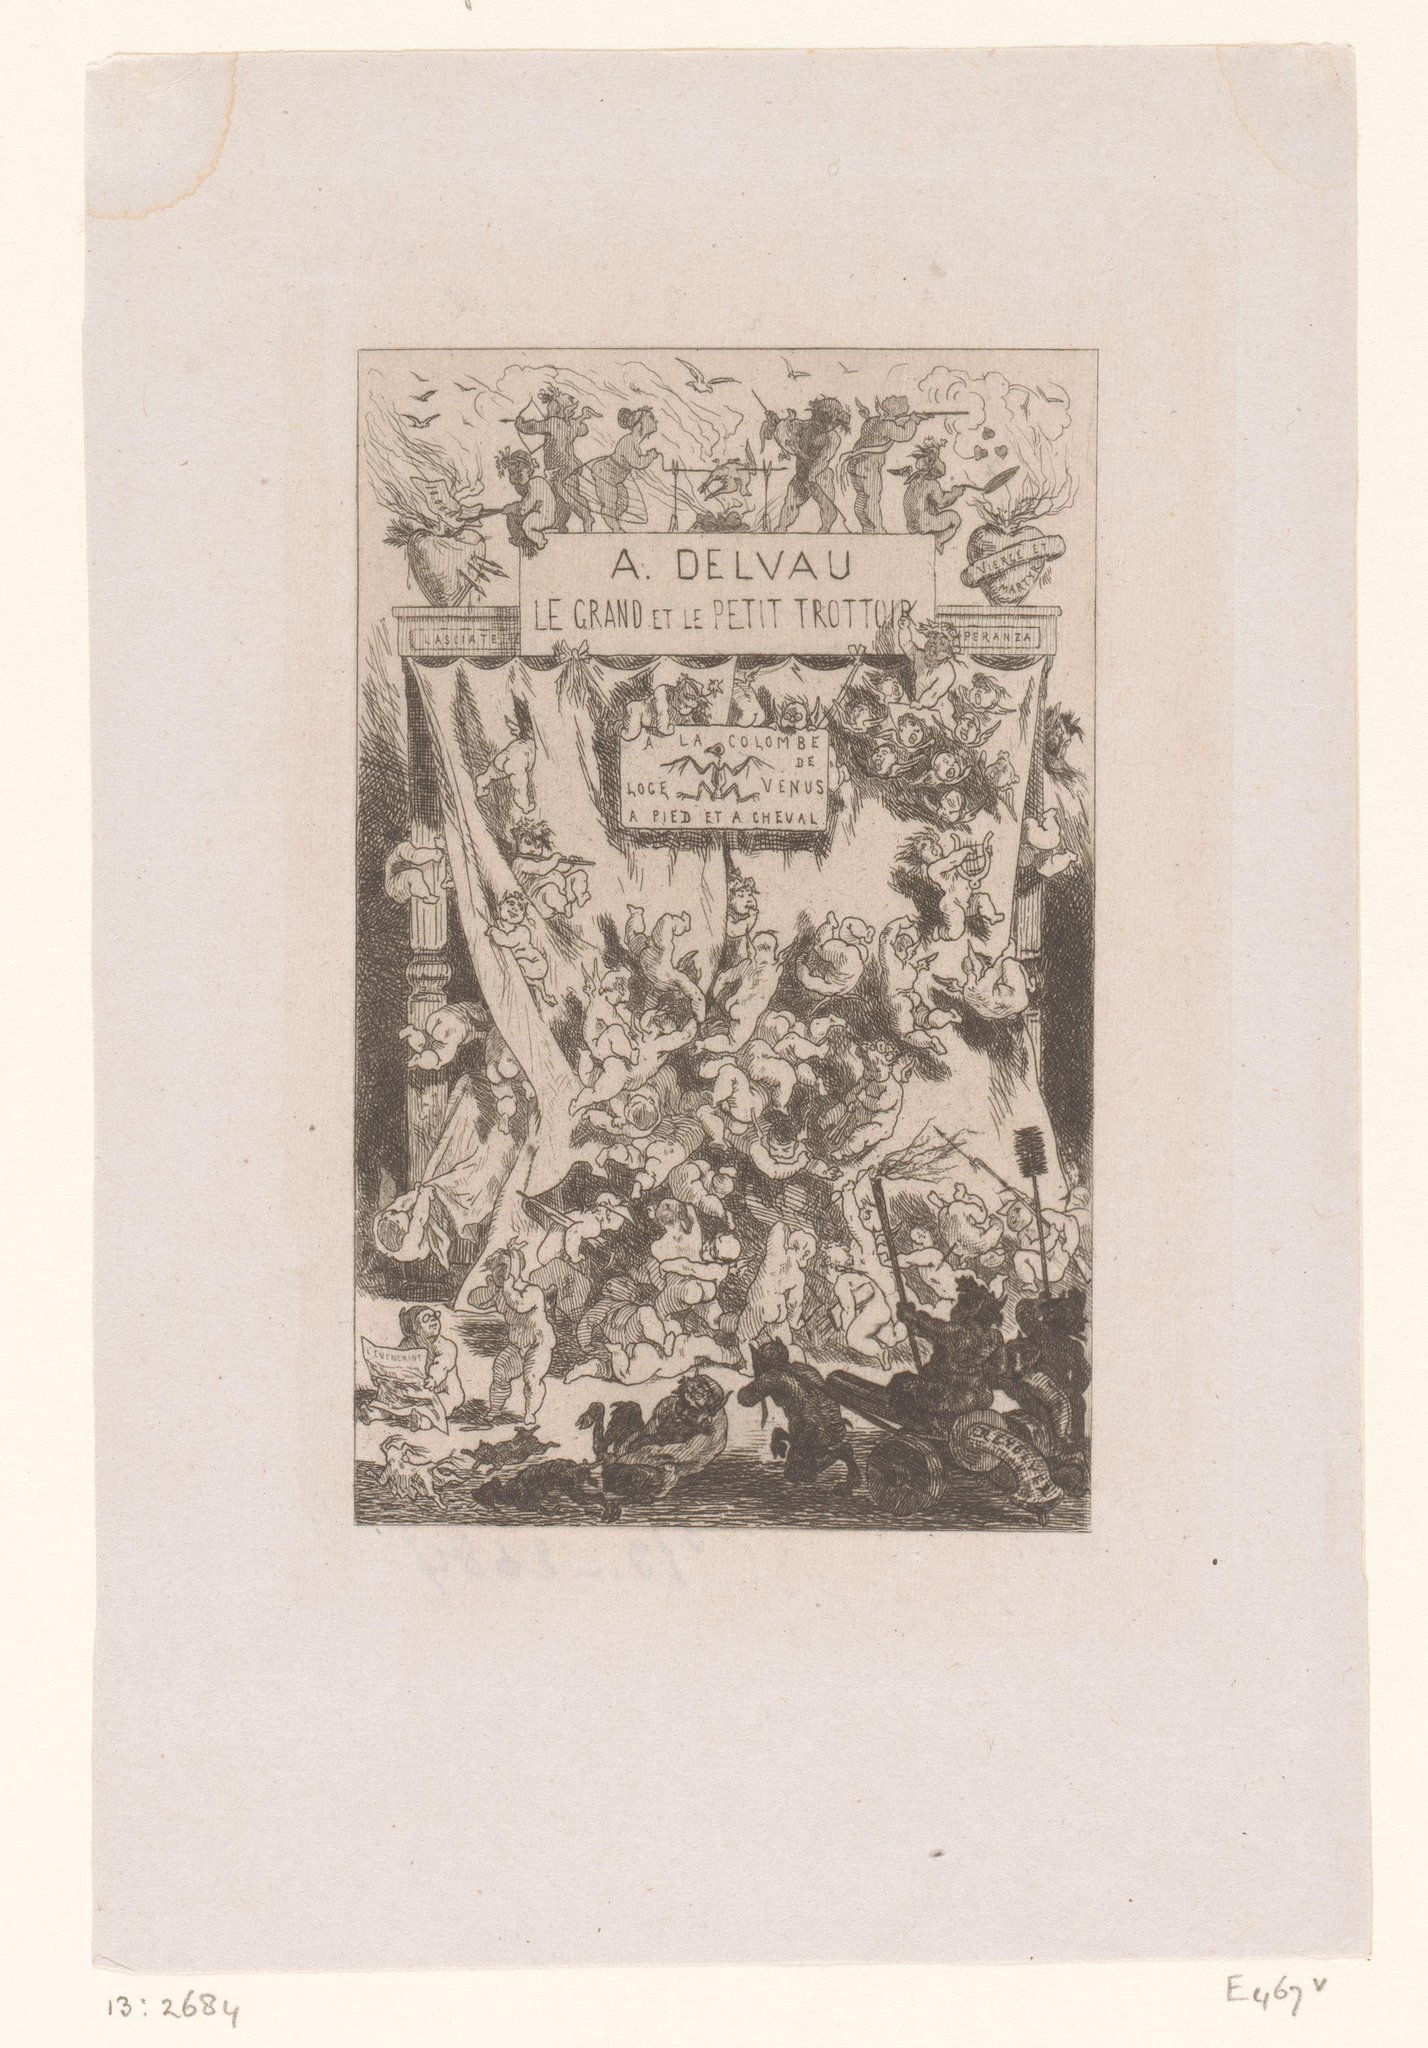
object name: print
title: A la colombe loge de Venus a pied et a cheval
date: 1866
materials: paper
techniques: drypoint, etching, intaglio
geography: paris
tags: cupids: 'amores', 'amoretti', 'putti'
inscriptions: collector's mark: Lugt 2228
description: Deze prent is gebruikt als illustratie tegenover de titelpagina van: Delvau, A. Le grand et le petit troittoir. Parijs: A. Faure, 1866.